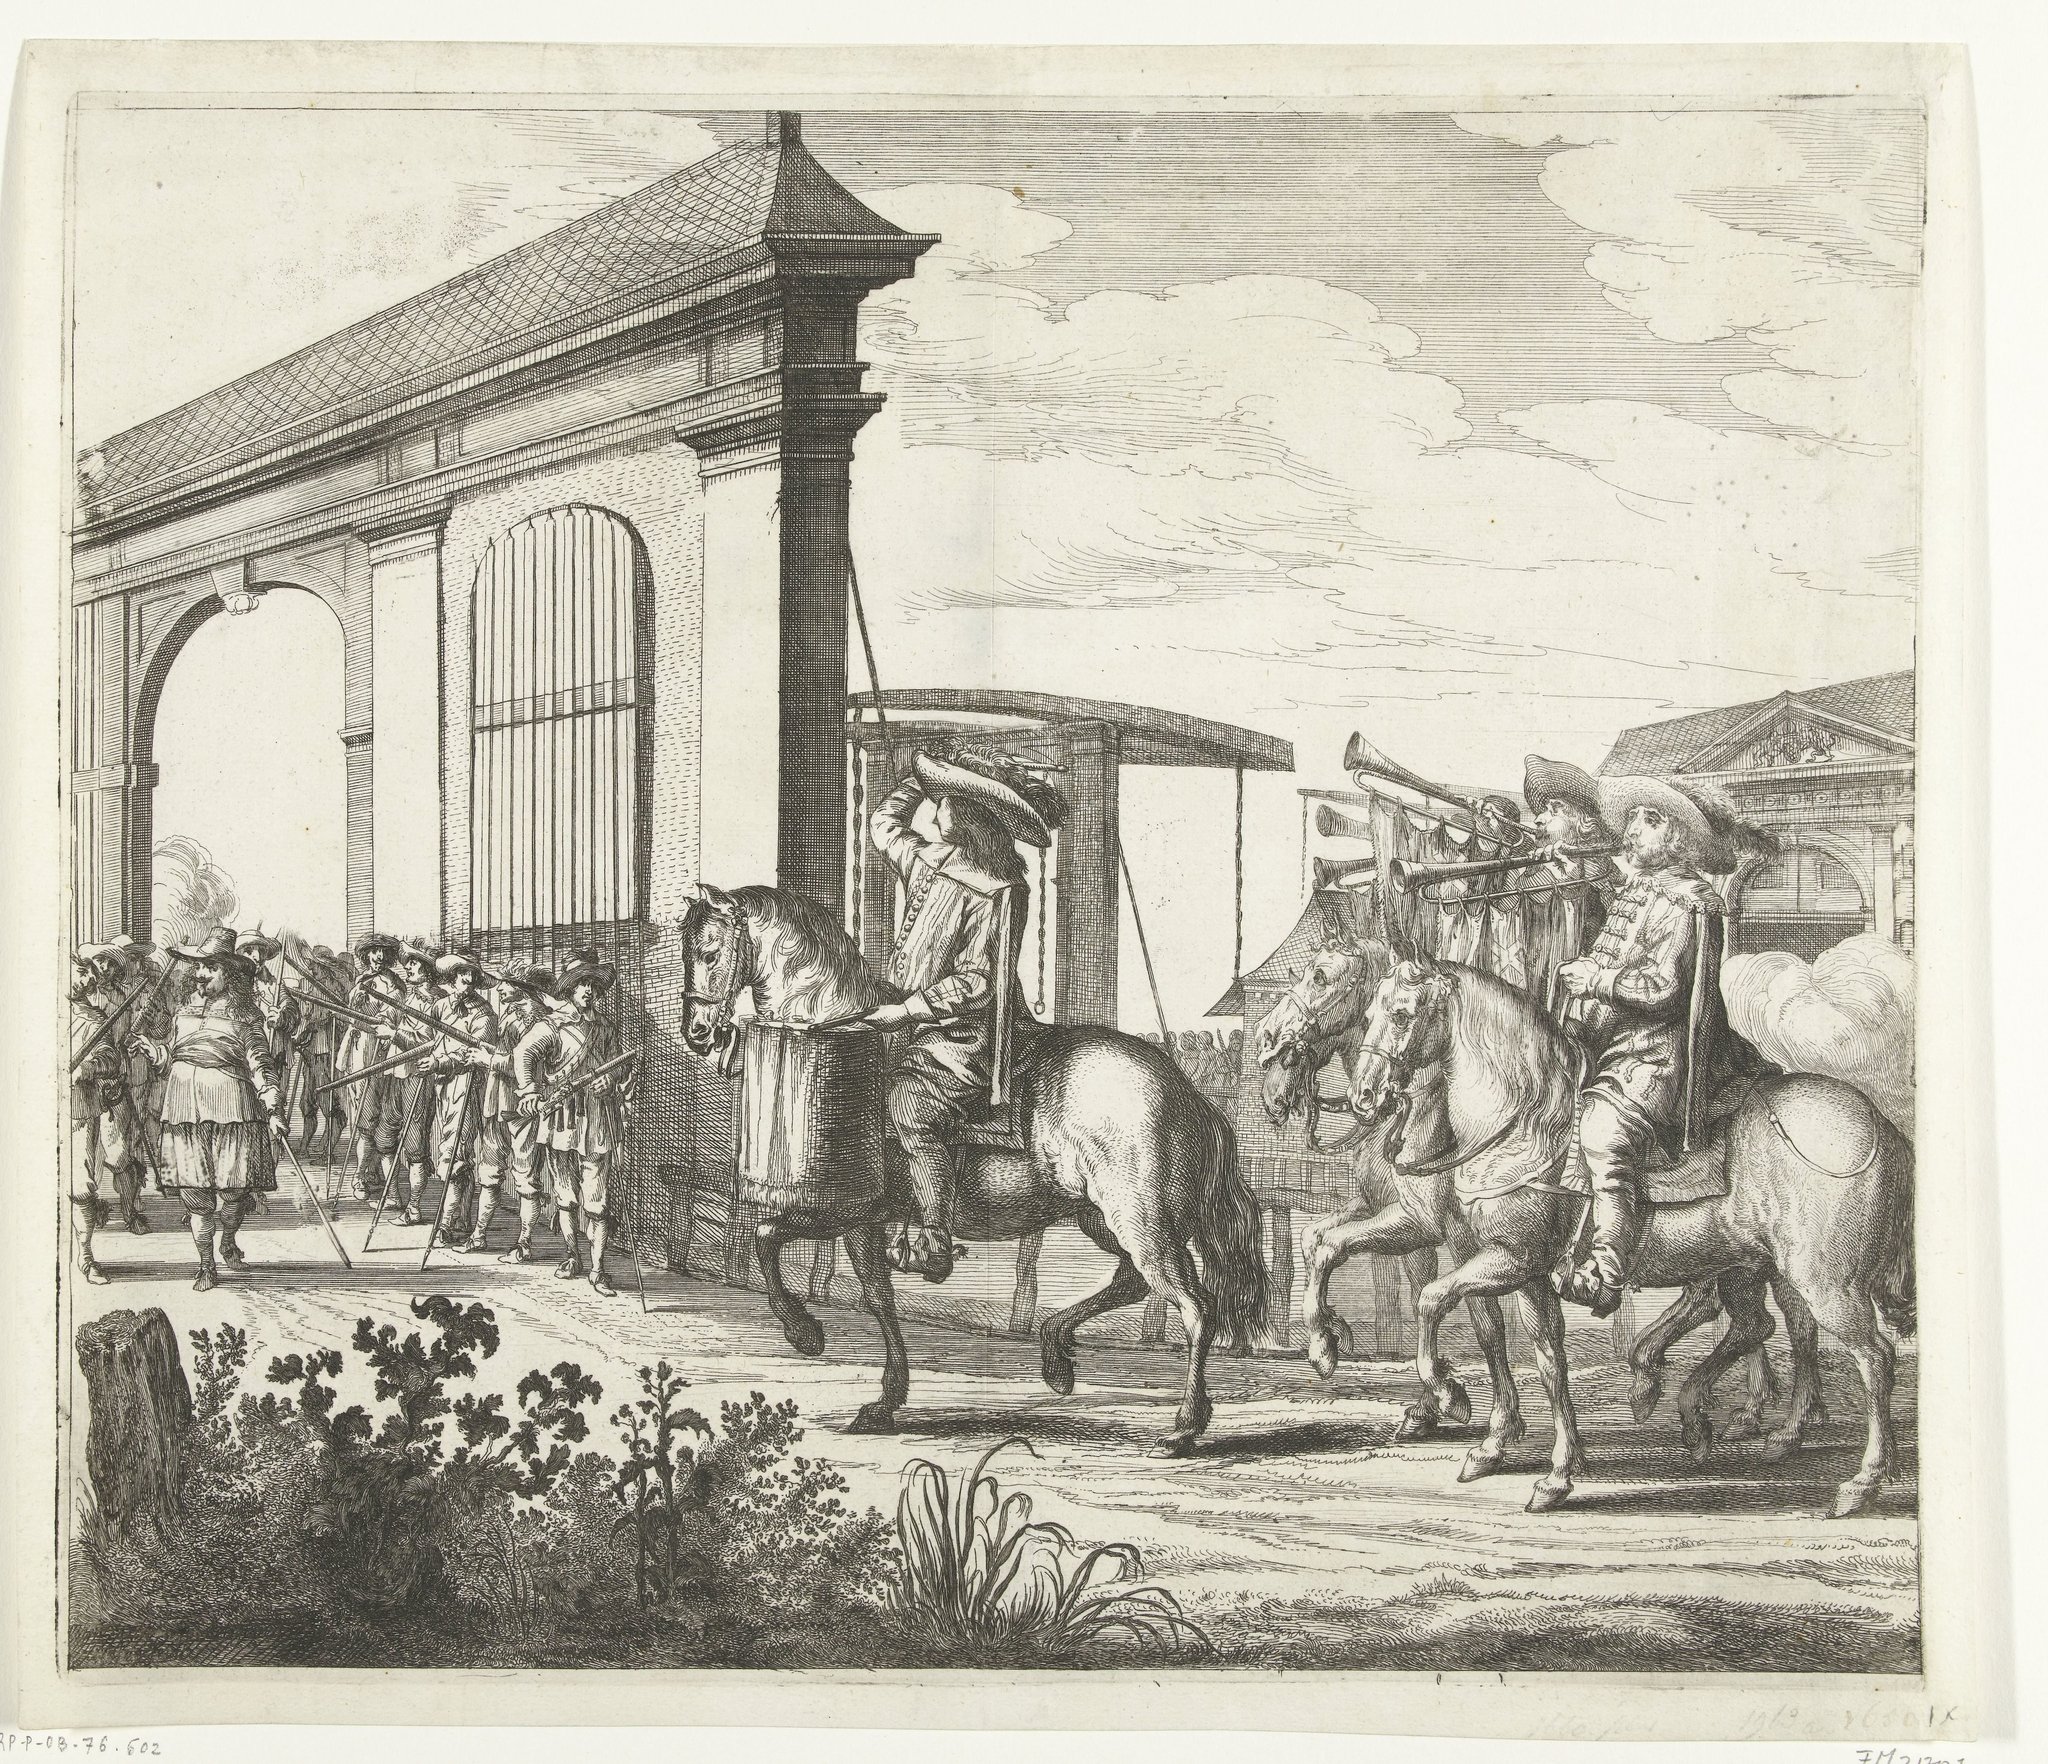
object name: print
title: Afbeelinghe op wat wijse haere Hoogheeden, Maria Stuart Princesse Rojael, en haeren Soon zijne Hoogheyt Wilhelm van Nassou, de III Prince van Orangien (...) op den 15 van Somermaent Ao. 1660 (...)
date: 1638-1639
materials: paper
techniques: engraving, etching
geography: northern netherlands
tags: william iii (prince of orange and king of england, scotland, and ireland), the hague, amalia of solms-braunfels, london, mary henrietta stuart, triumphal entry and public reception, pageant, 'entrée solennelle', 'joyeuse entrée'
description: Bezoek van de Maria Henrietta Stuart, prinses van Oranje, vergezeld door Amalia van Solms, de jonge prins Willem III en anderen te Amsterdam, 15 juni 1660. De aankomst van de stoet bij de Haarlemmerpoort, voorop drie trompetters. Eerste plaat in een ongemonteerd ensemble bestaande uit een zeven bladen van de stoet.